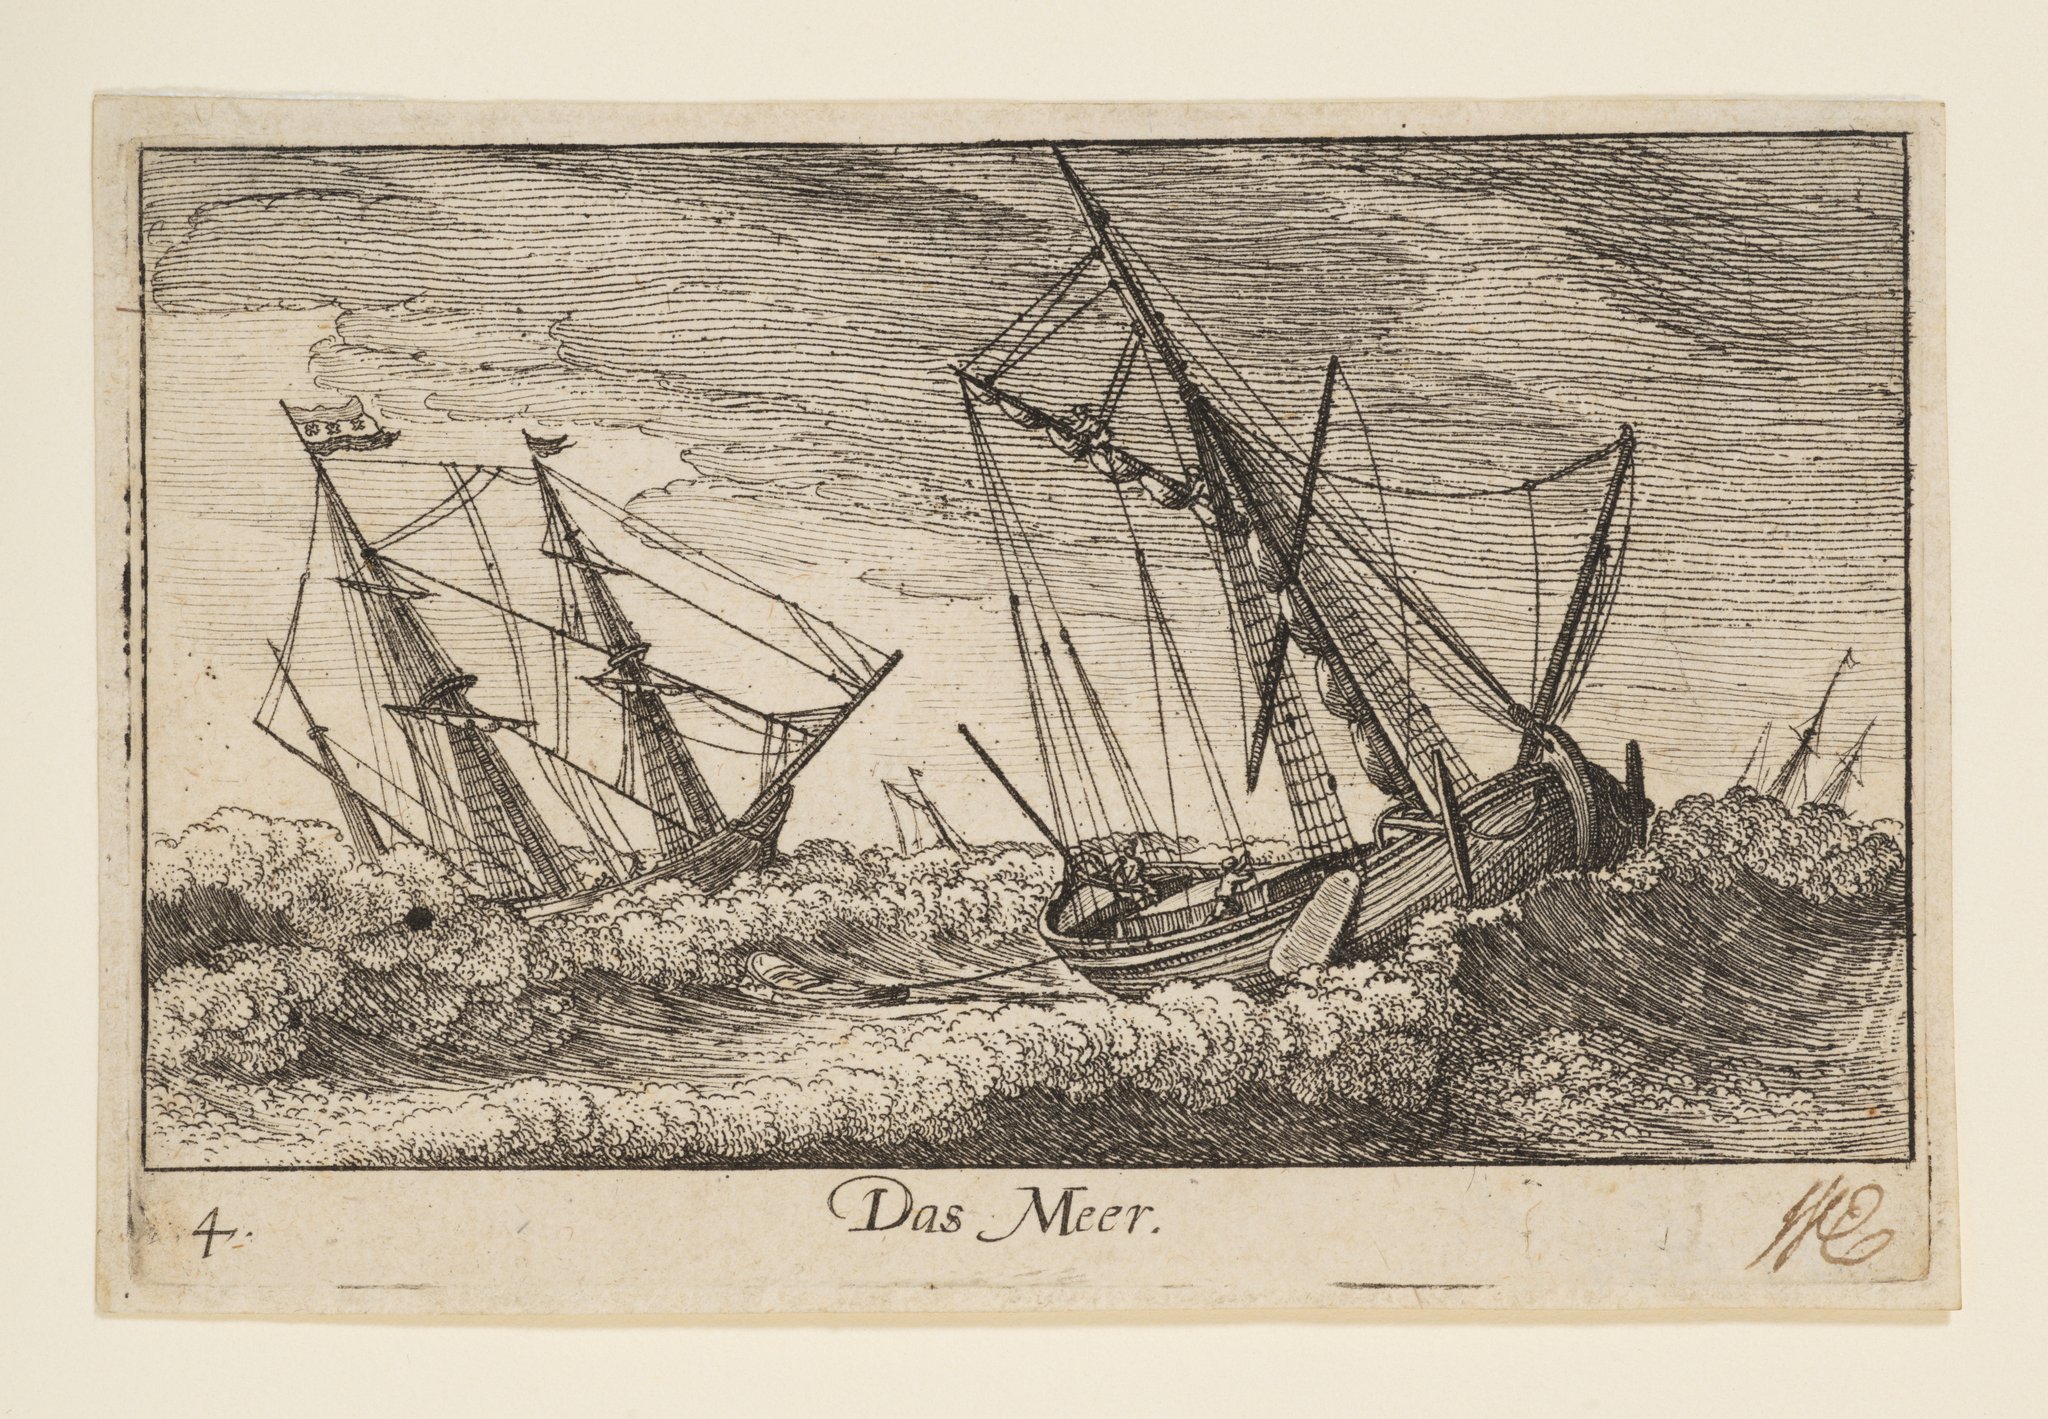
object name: print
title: The Sea (Das Meer)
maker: wenceslaus hollar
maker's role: artist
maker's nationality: bohemian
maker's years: 1607-1677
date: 1635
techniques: etching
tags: ships